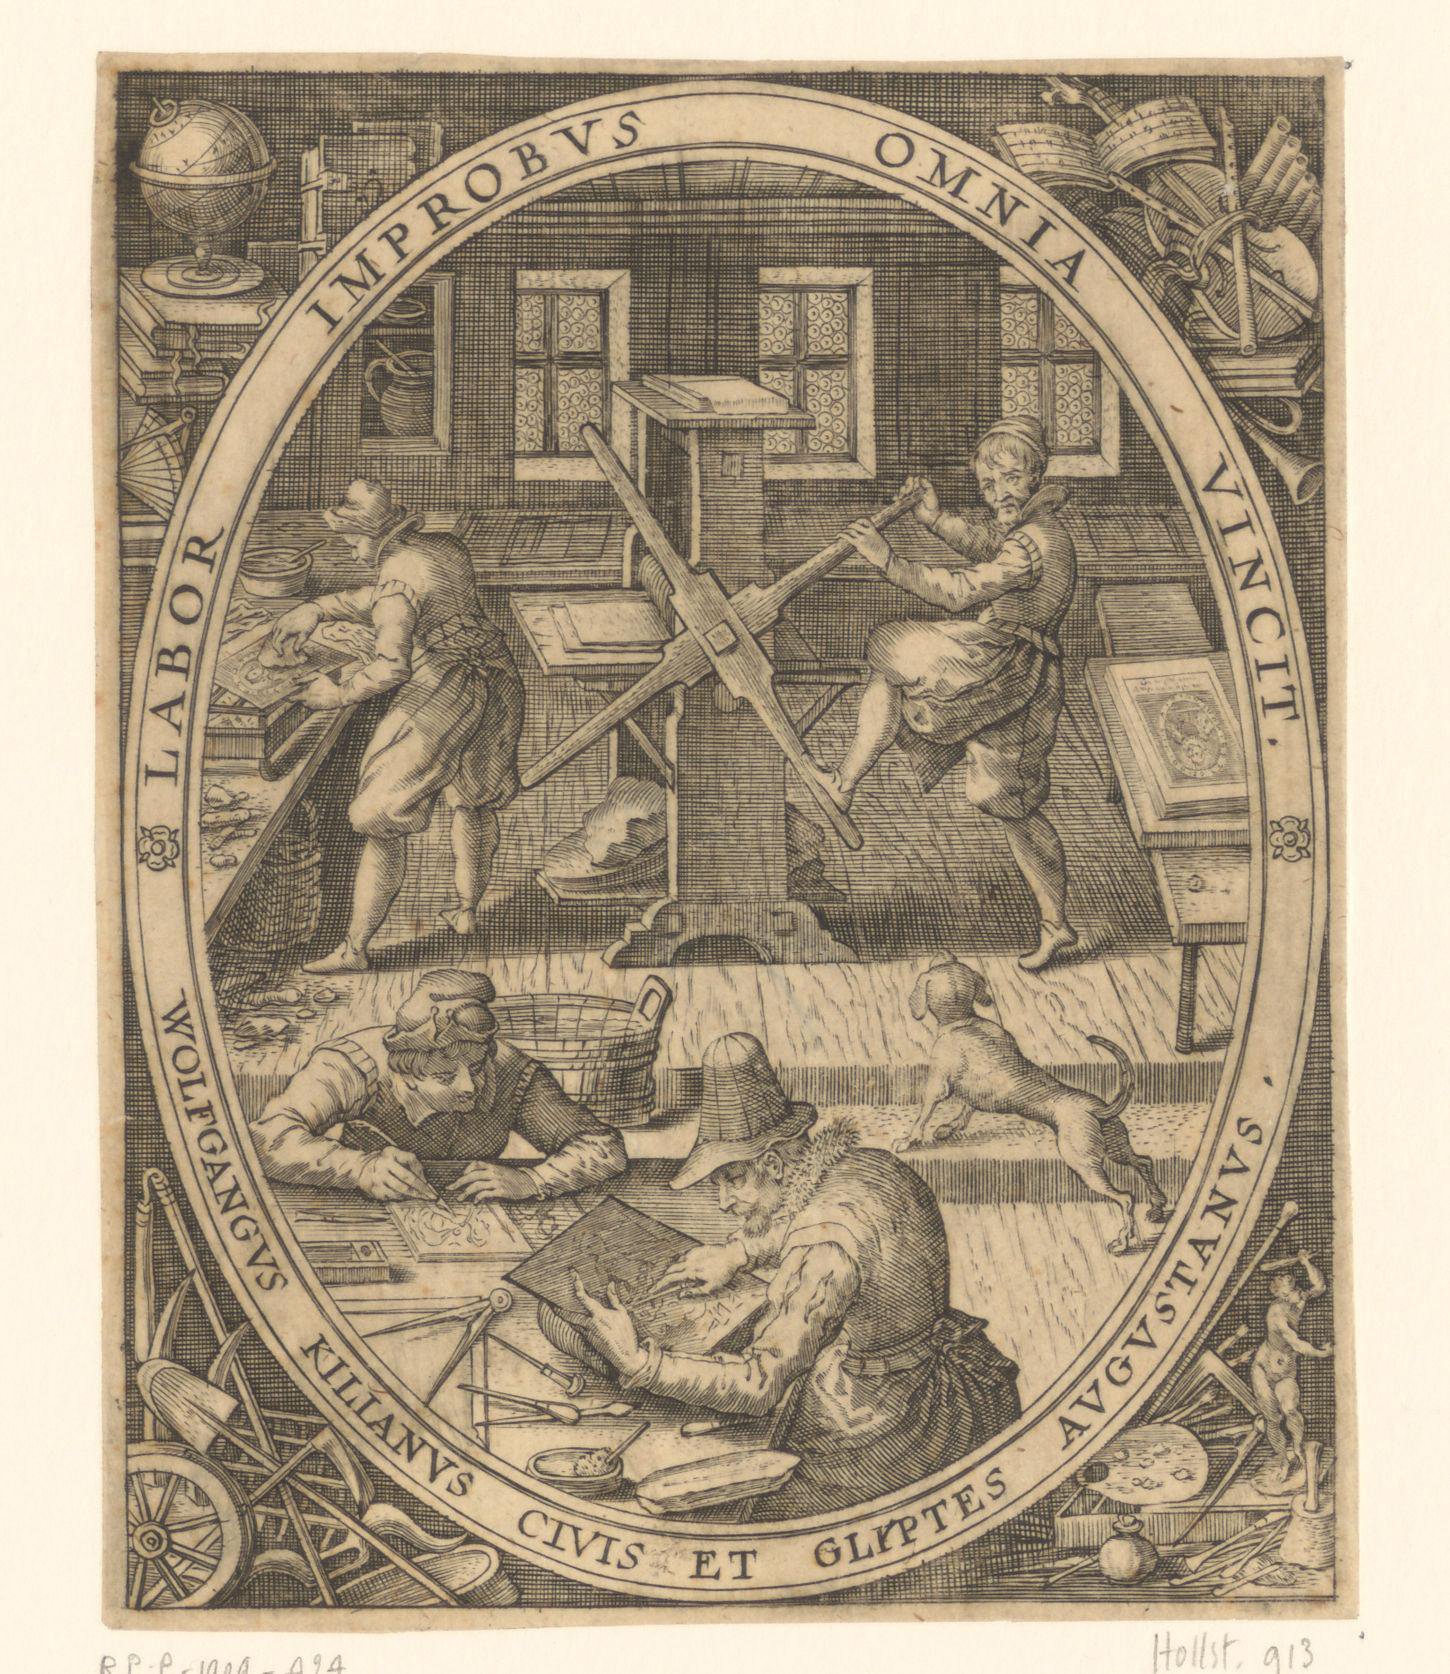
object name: printer's mark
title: Werkplaats en drukkerij van Wolfgang Kilian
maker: wolfgang kilian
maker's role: print maker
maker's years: 1581-1662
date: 1591-1662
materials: paper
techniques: engraving, etching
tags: engraver, etcher, artist at work, in his workshop (+ graphic arts), printing press, tools, implements of graphic artist, tools, implements of printer, graphic artist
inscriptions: collector's mark: Lugt 2228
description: Drukkersmerk van de prentdrukkerij van Wolfgang Kilian. Verschillende prentmakers zijn aan het werk. Tekst in het Latijn in de omlijsting: Labor improbus omnia vincit/ Wolfgangus Kilianus civis et glyptes augustanus.